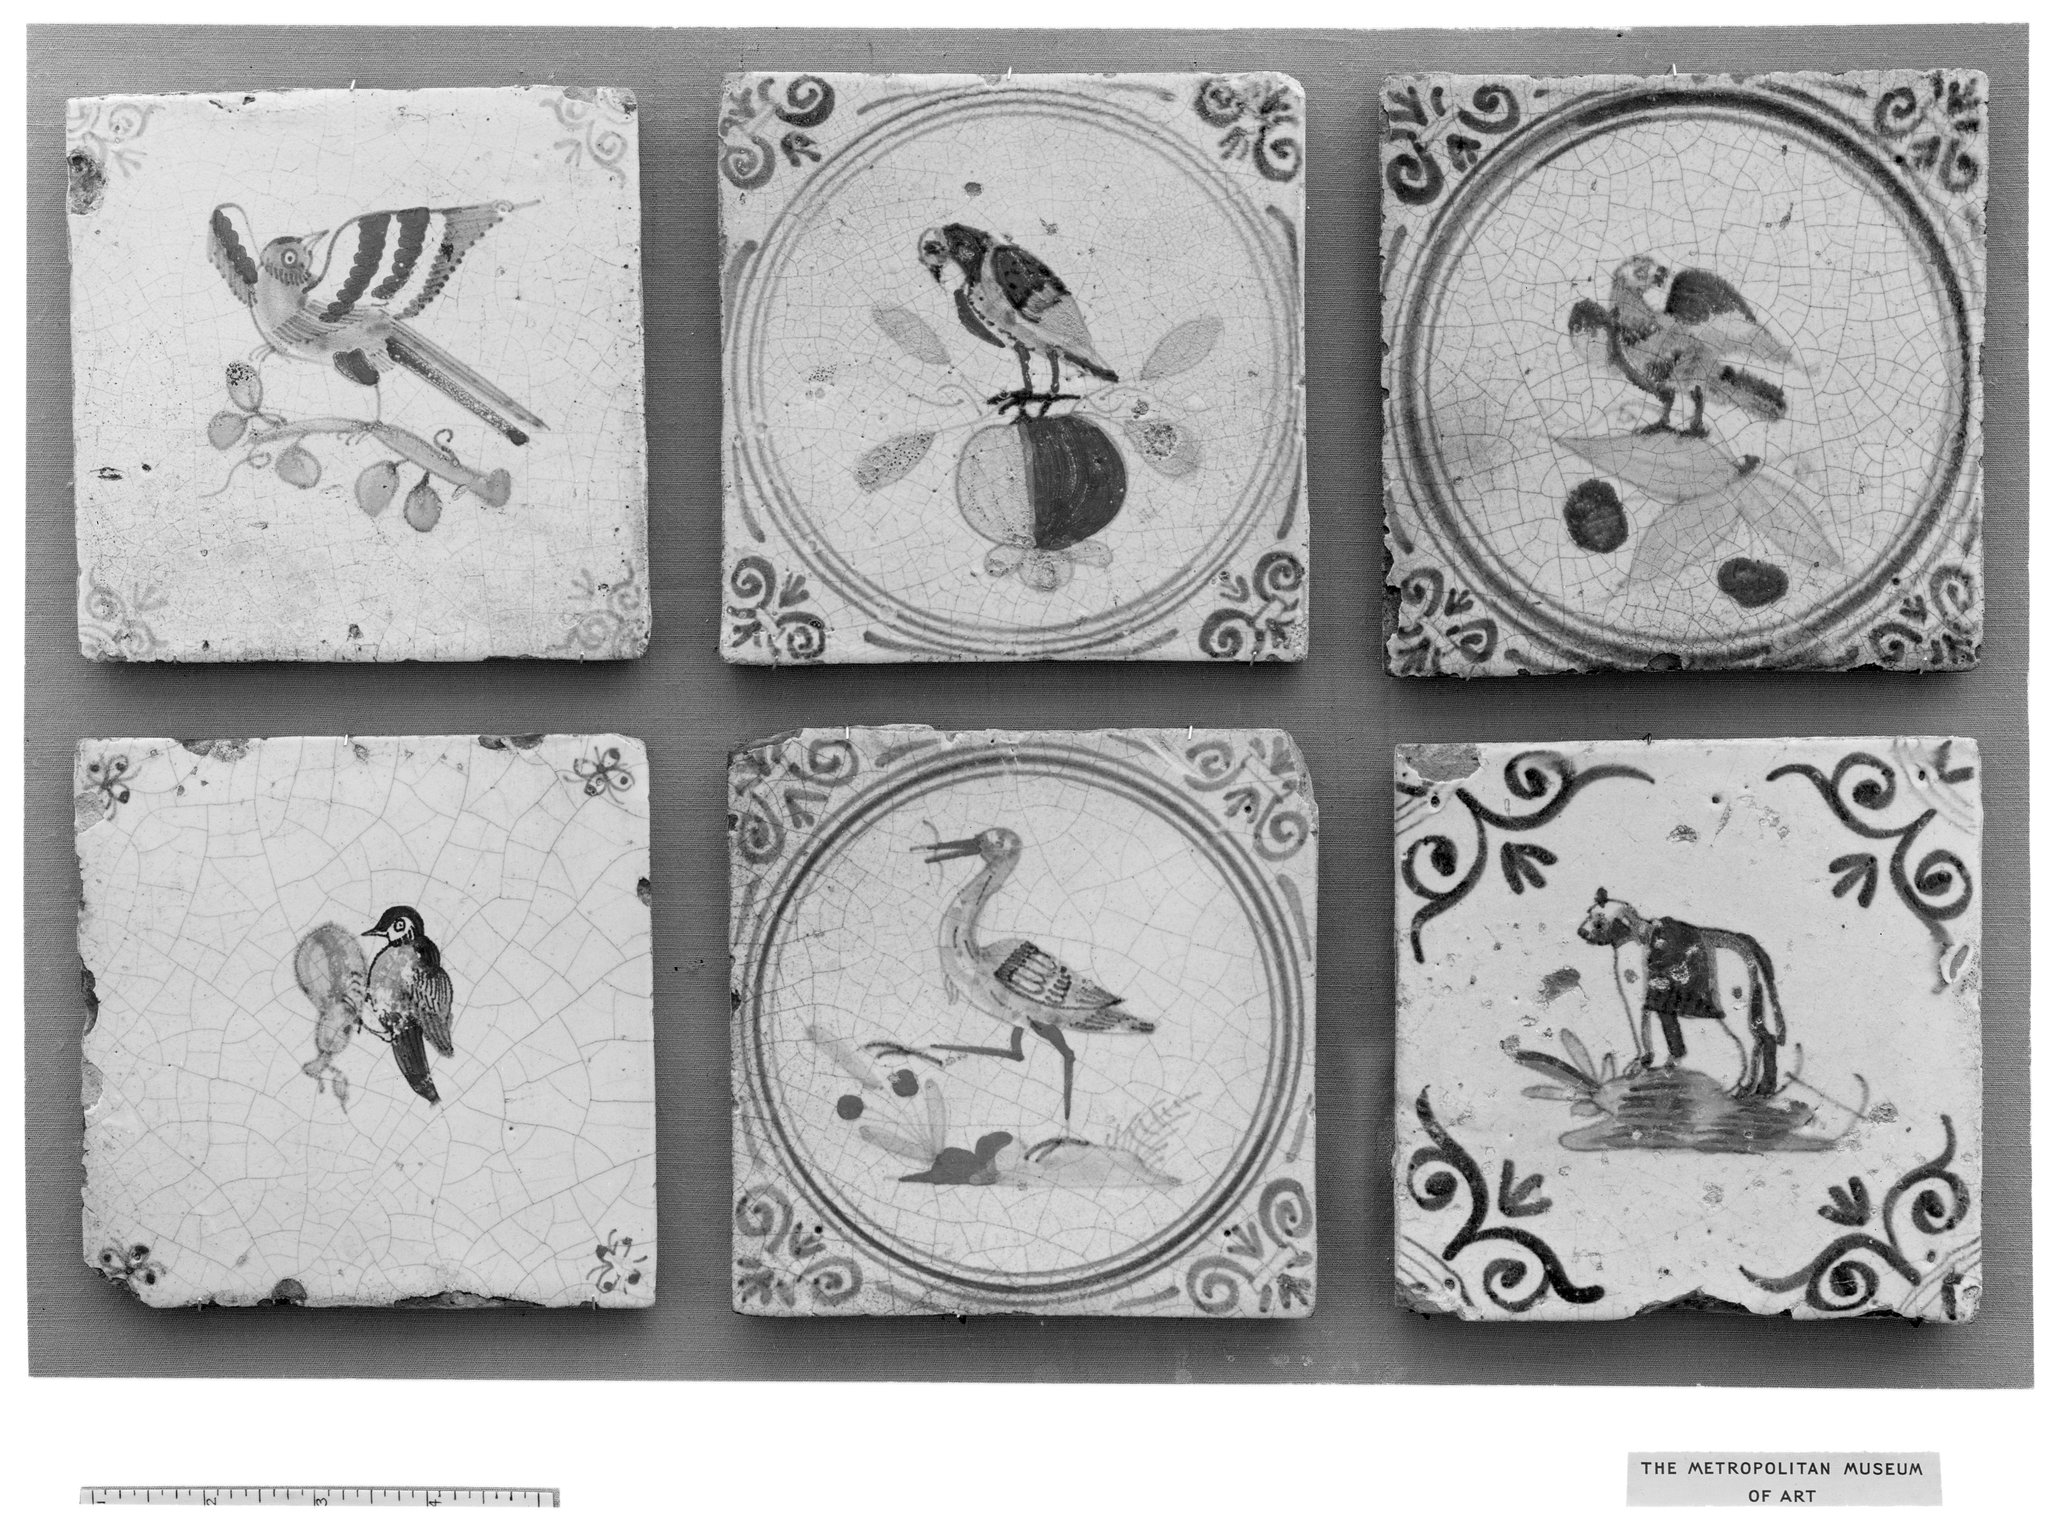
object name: tile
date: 1701-1800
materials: earthenware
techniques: glazing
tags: birds,cranes,eagles,dogs